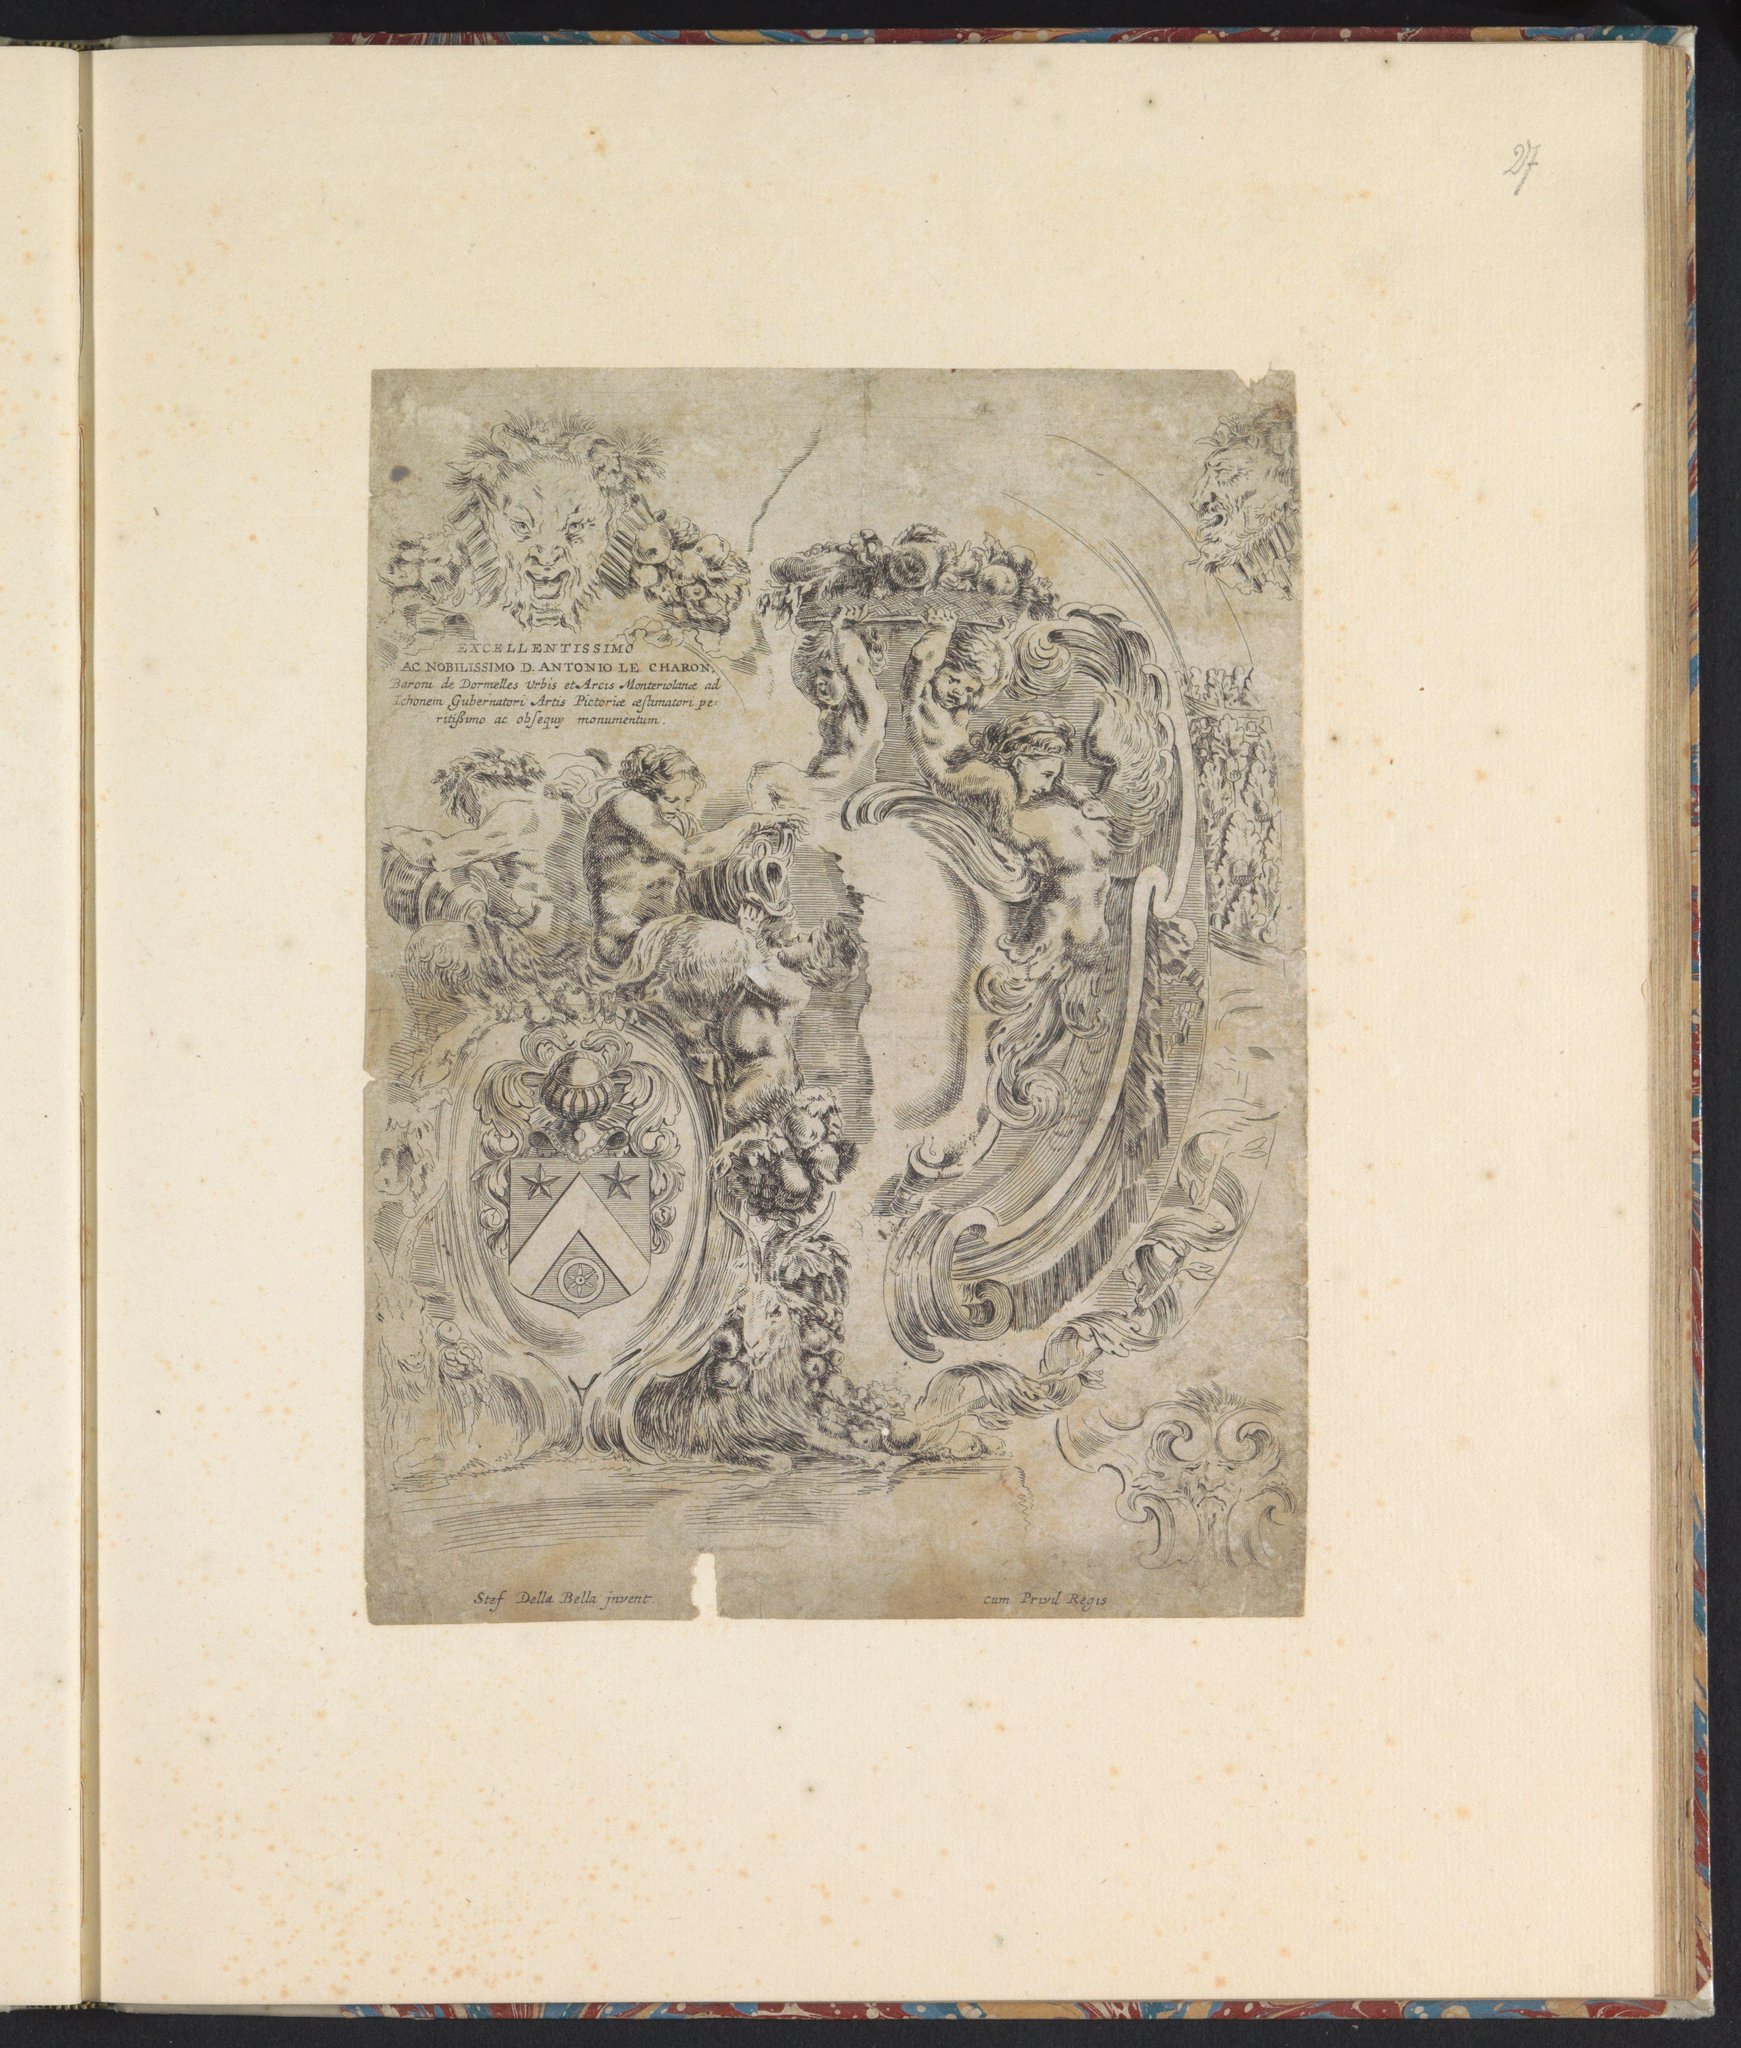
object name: print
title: Twee cartouches en drie groteske maskers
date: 1645-1750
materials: paper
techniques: etching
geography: france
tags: armorial bearing, heraldry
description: Links een cartouche met bovenop een mannelijke en een vrouwelijke sater met kruiken. Daaronder twee liggende geiten. Rechts de rechterhelft van een groter cartouche met twee jonge saters die een fruitmand ondersteunen en een harpij. In de hoeken linksboven, rechtsboven en rechtsonder groteske maskers. De prent maakt deel uit van een album.